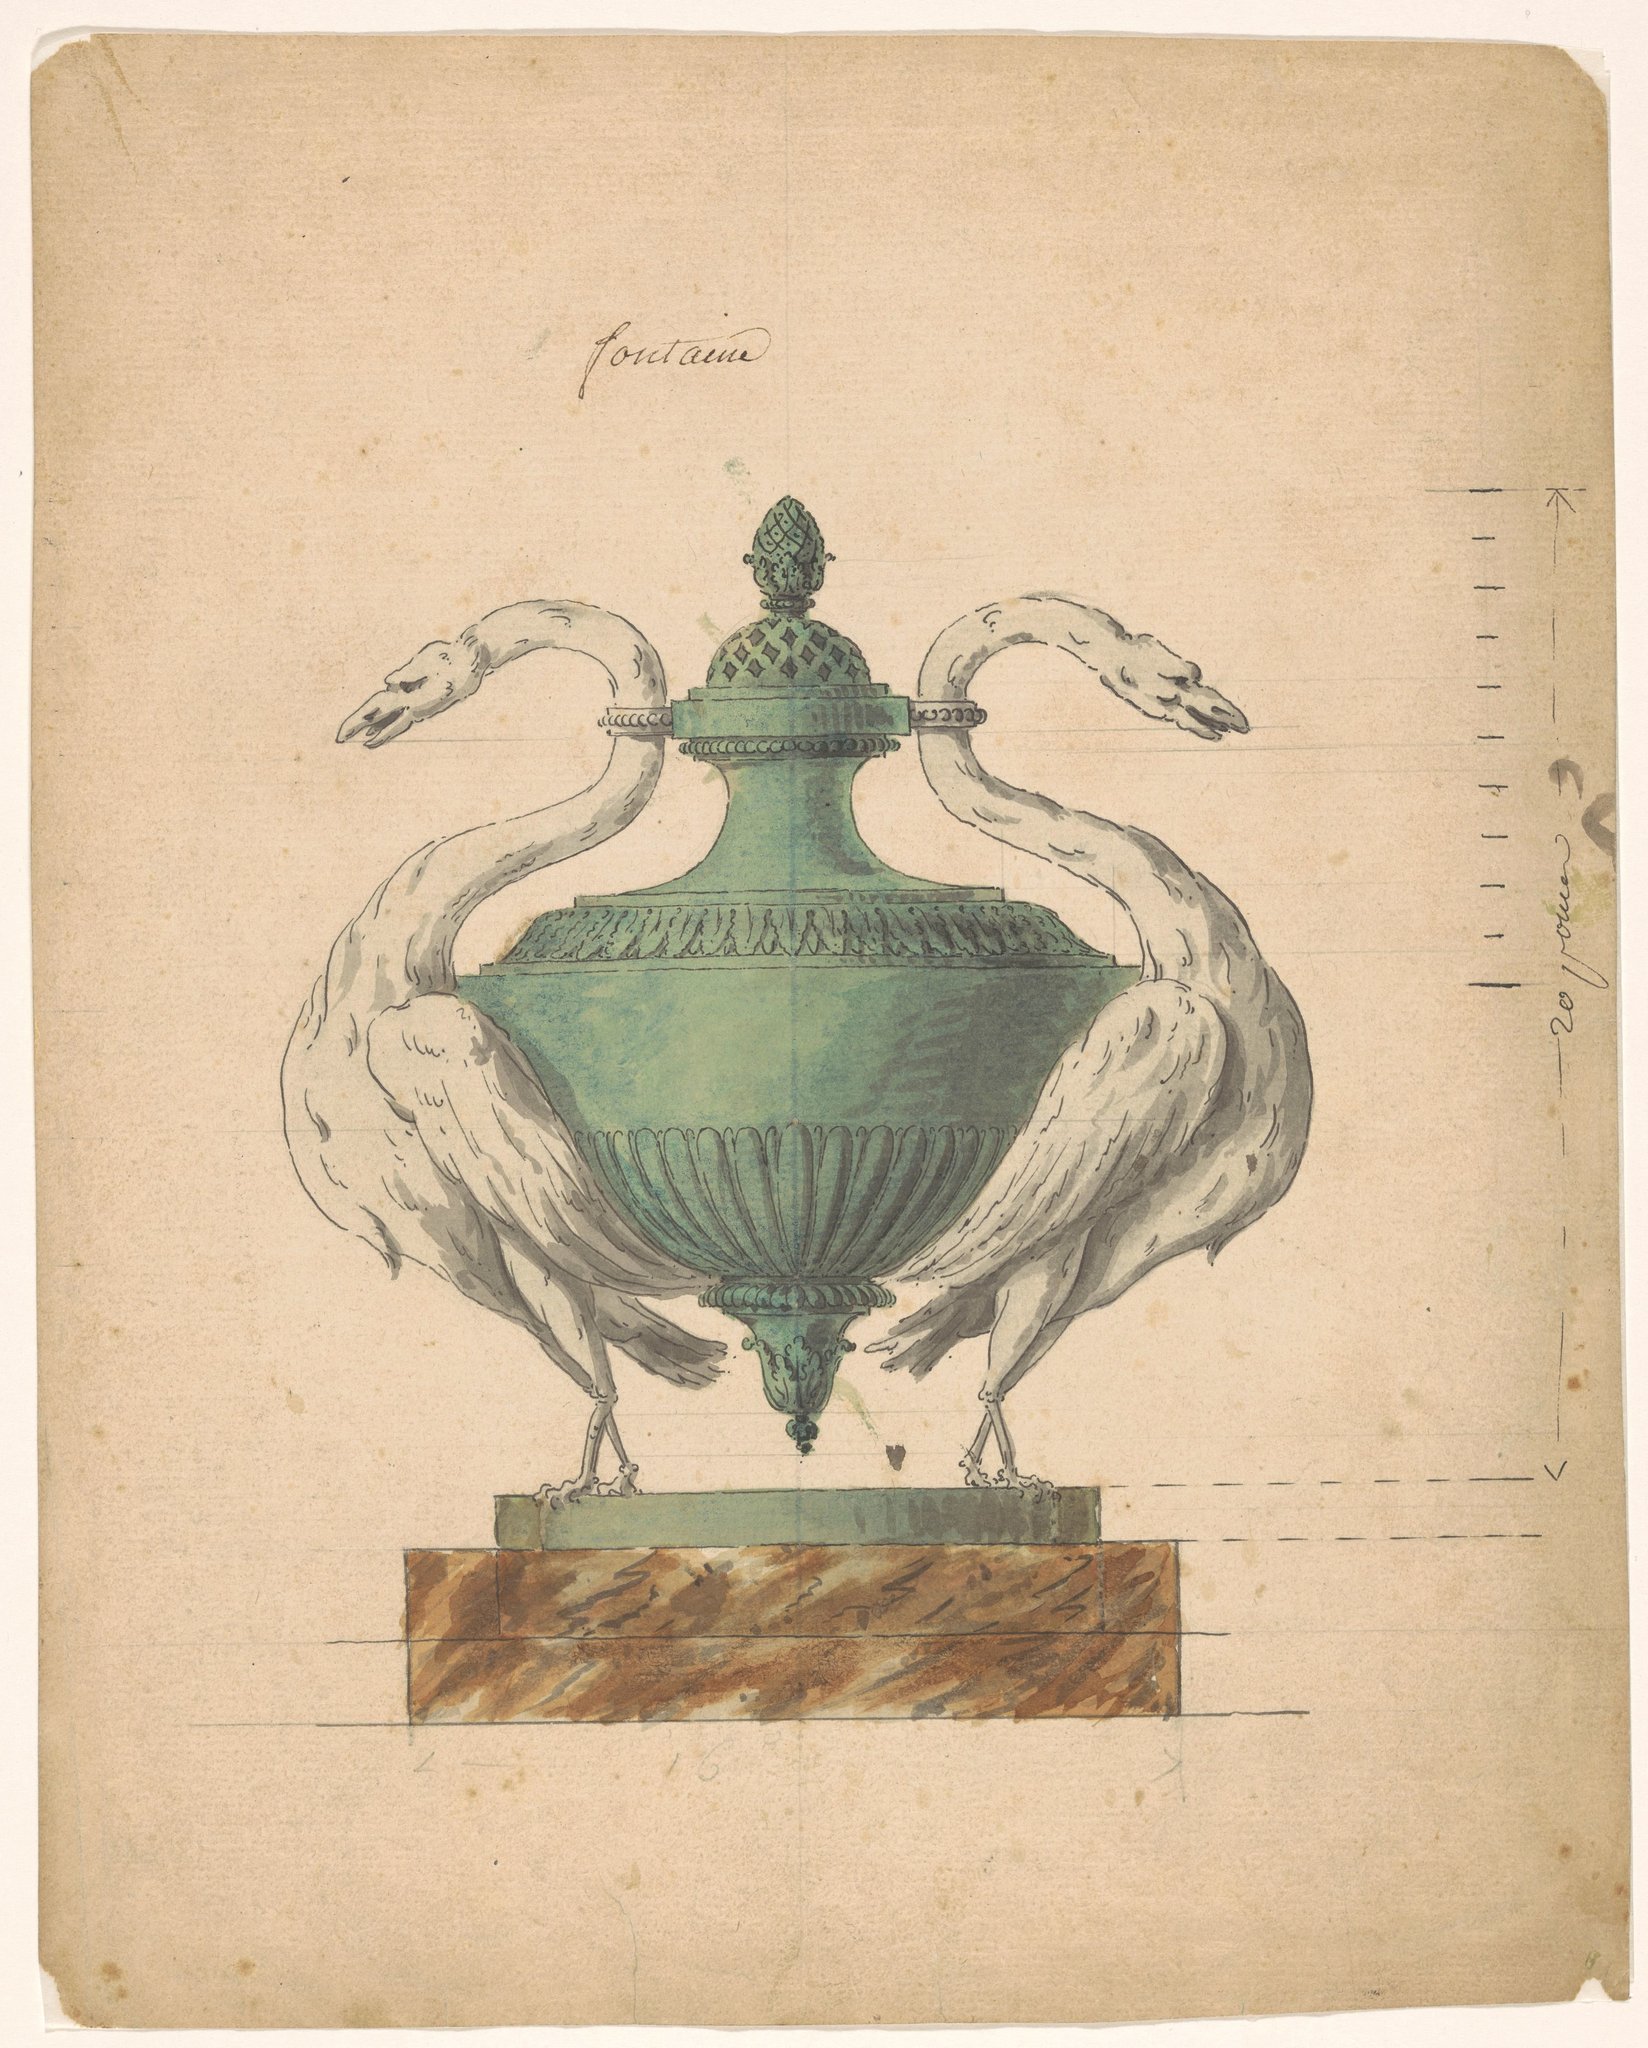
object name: drawing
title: Ontwerptekening voor een gepatineerd bronzen reukvaas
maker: Anonymous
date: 1780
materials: cardboard, graphite, ink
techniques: brush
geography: paris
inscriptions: inscription: ‘fontaine’, size: ‘maataanduidingen en een schaalverdeling met langs de rechterzijde 20 pouces langs de onderzijde in grafiet: maataanduiding 16 (grotendeels uitgevlakt).’, watermark: ‘druiventros (?)’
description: Gepatineerd bronzen reukvaas, gedragen door twee verzilverde zwanen, rustend op een marmeren voet.